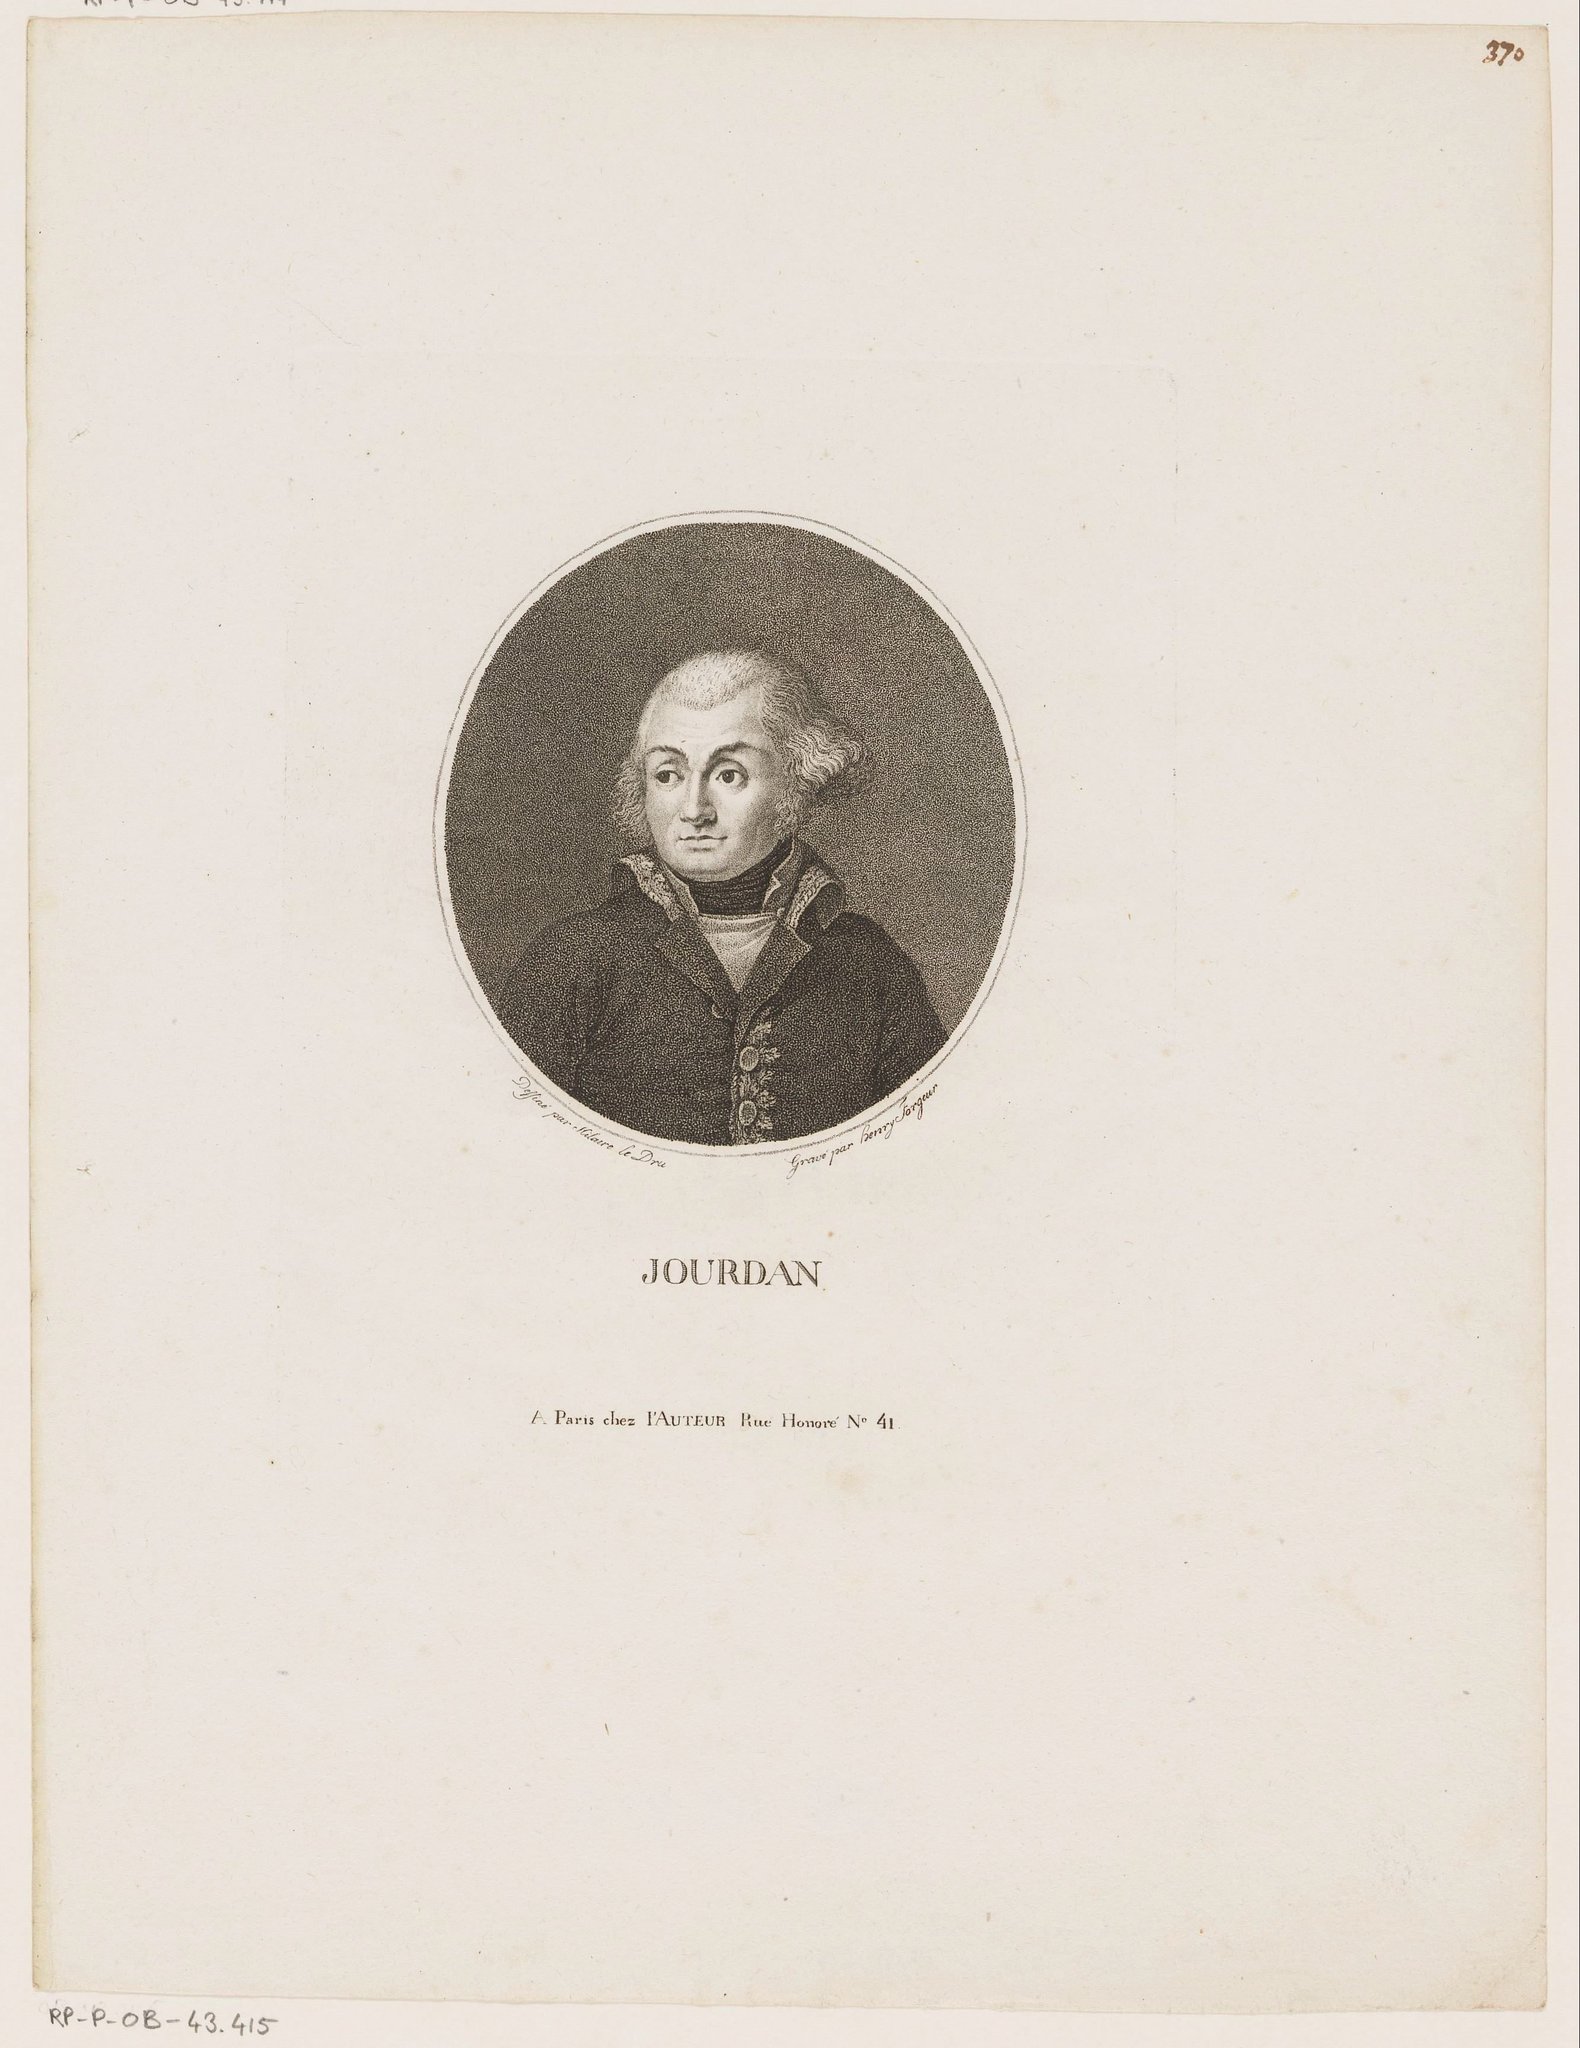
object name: print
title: Portret van Jean-Baptiste Jourdan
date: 1700-1799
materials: paper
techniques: engraving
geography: france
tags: paris, politician, commander-in-chief, general, marshal, historical persons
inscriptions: collector's mark: Lugt 2228, number: ‘370’